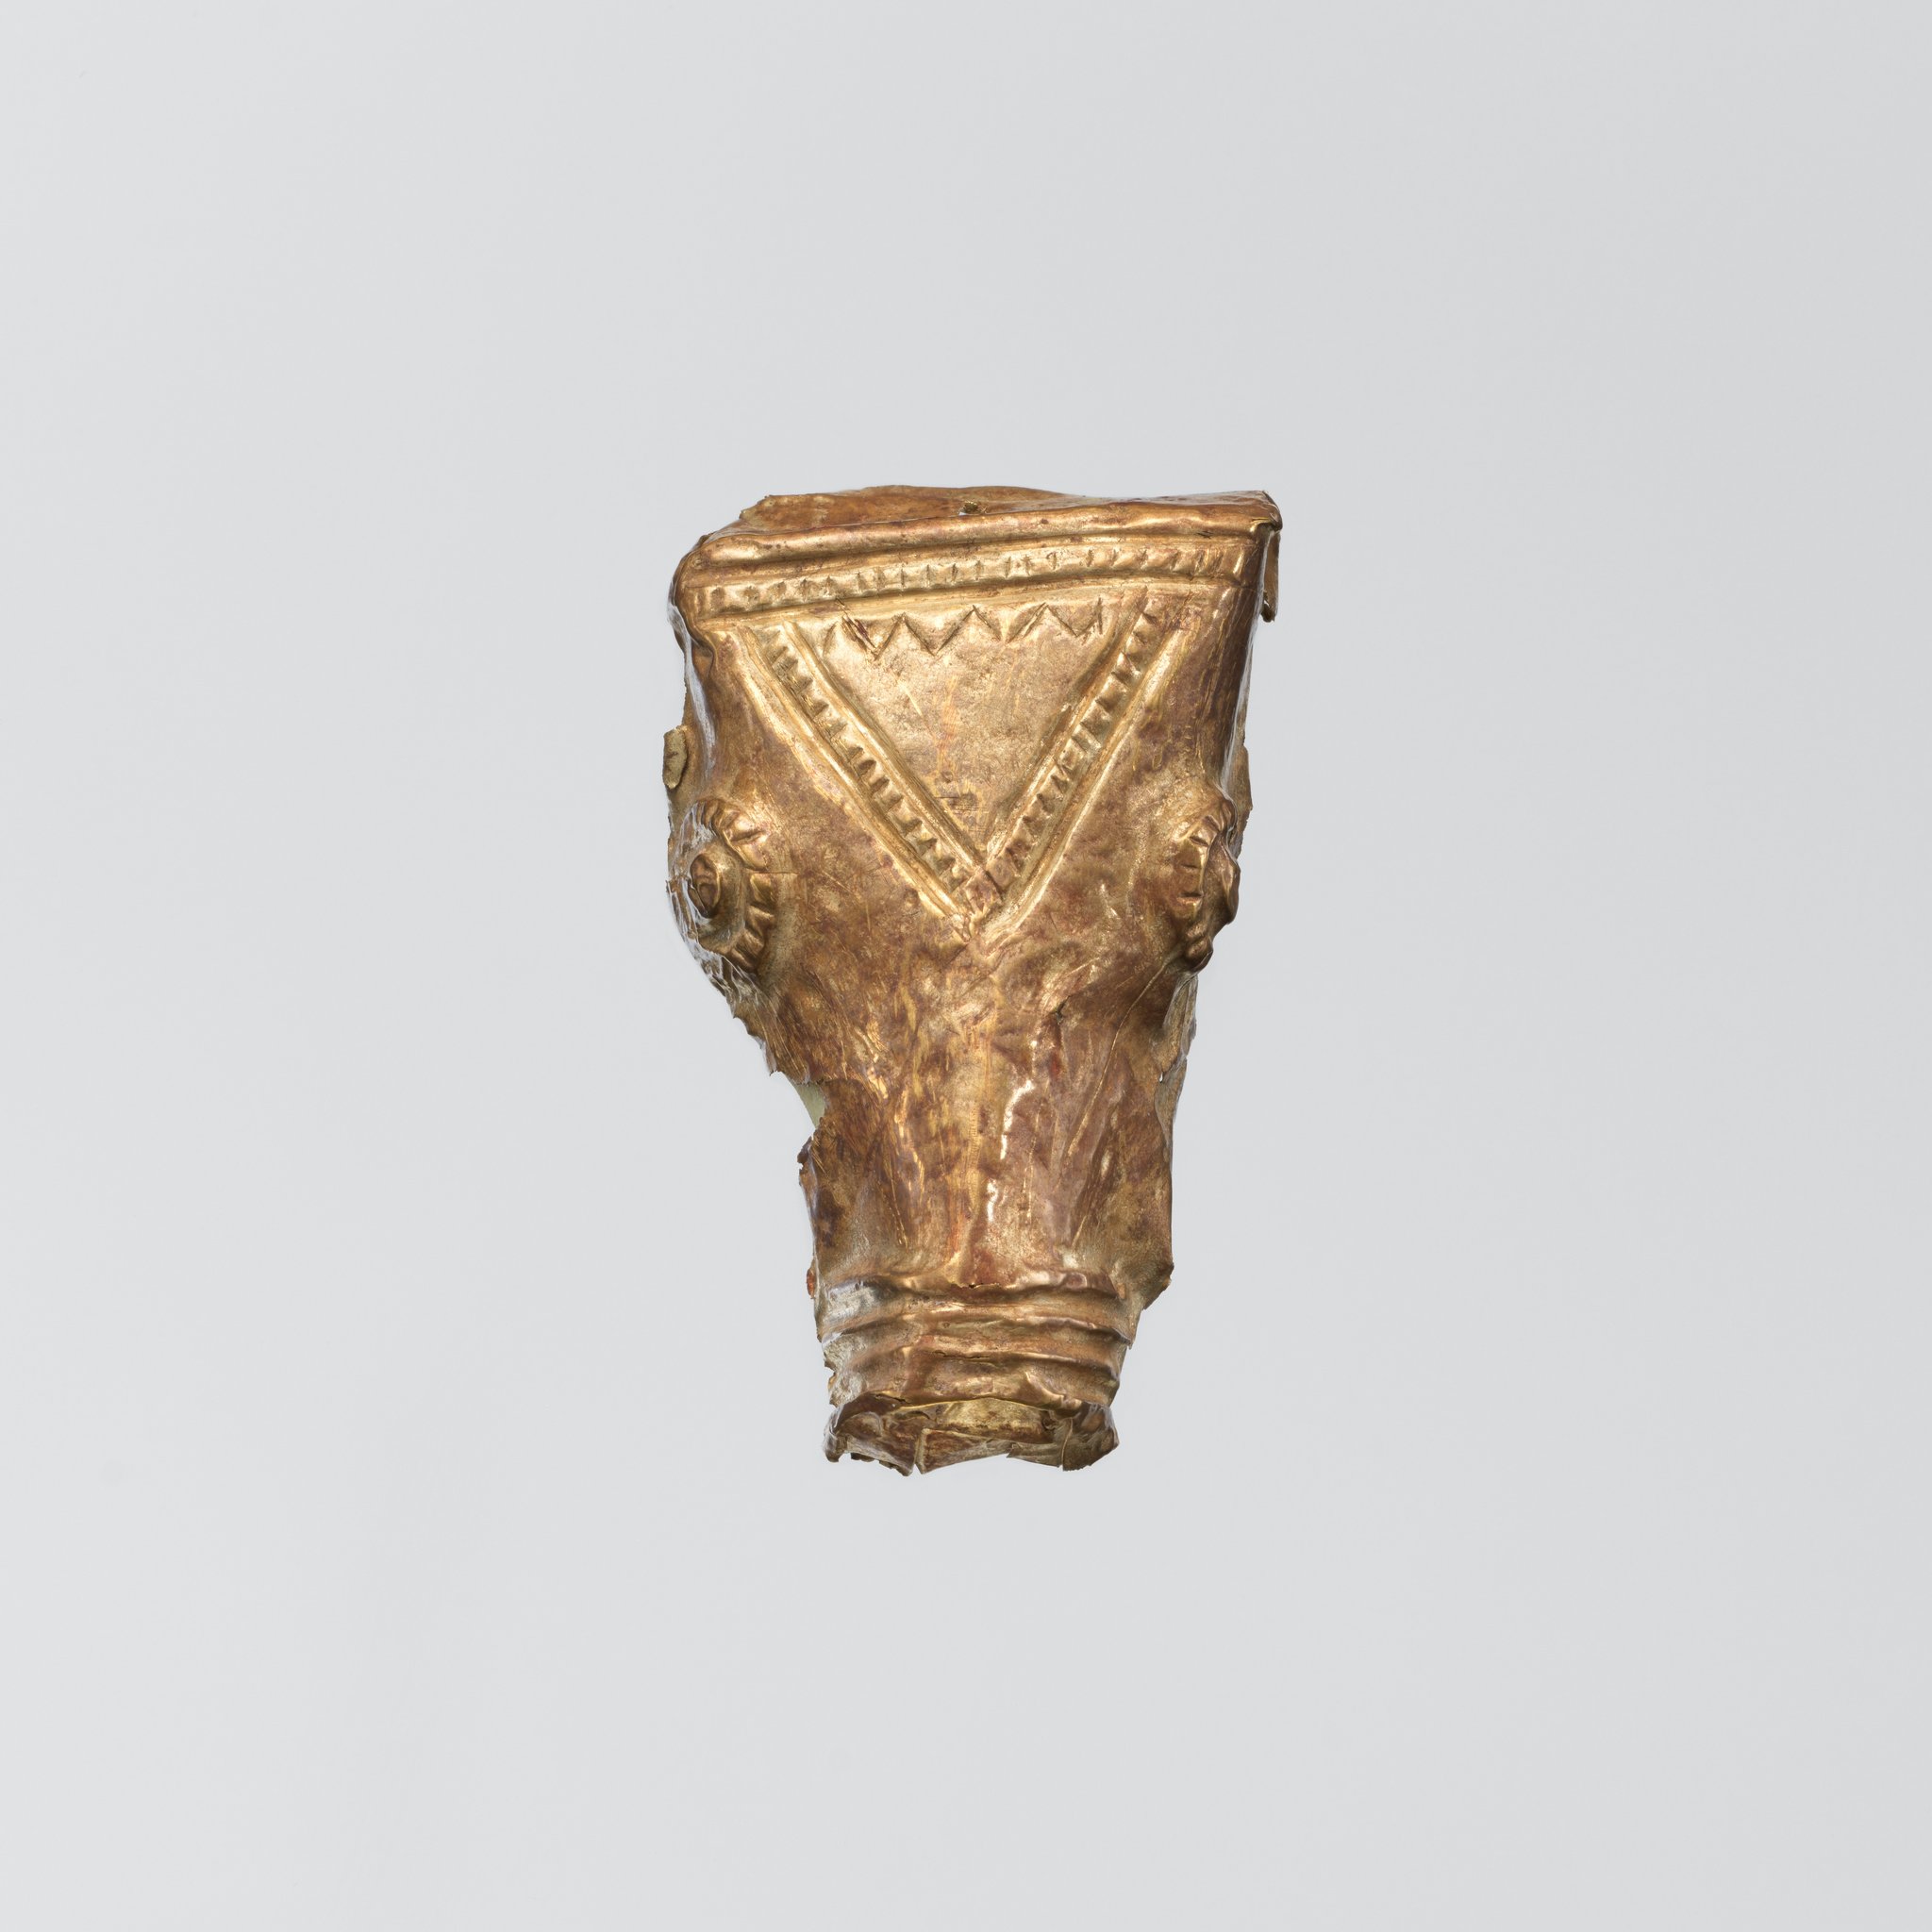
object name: earring, boat shaped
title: Gold bull's head applique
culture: cypriot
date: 1200-1050 BCE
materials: gold